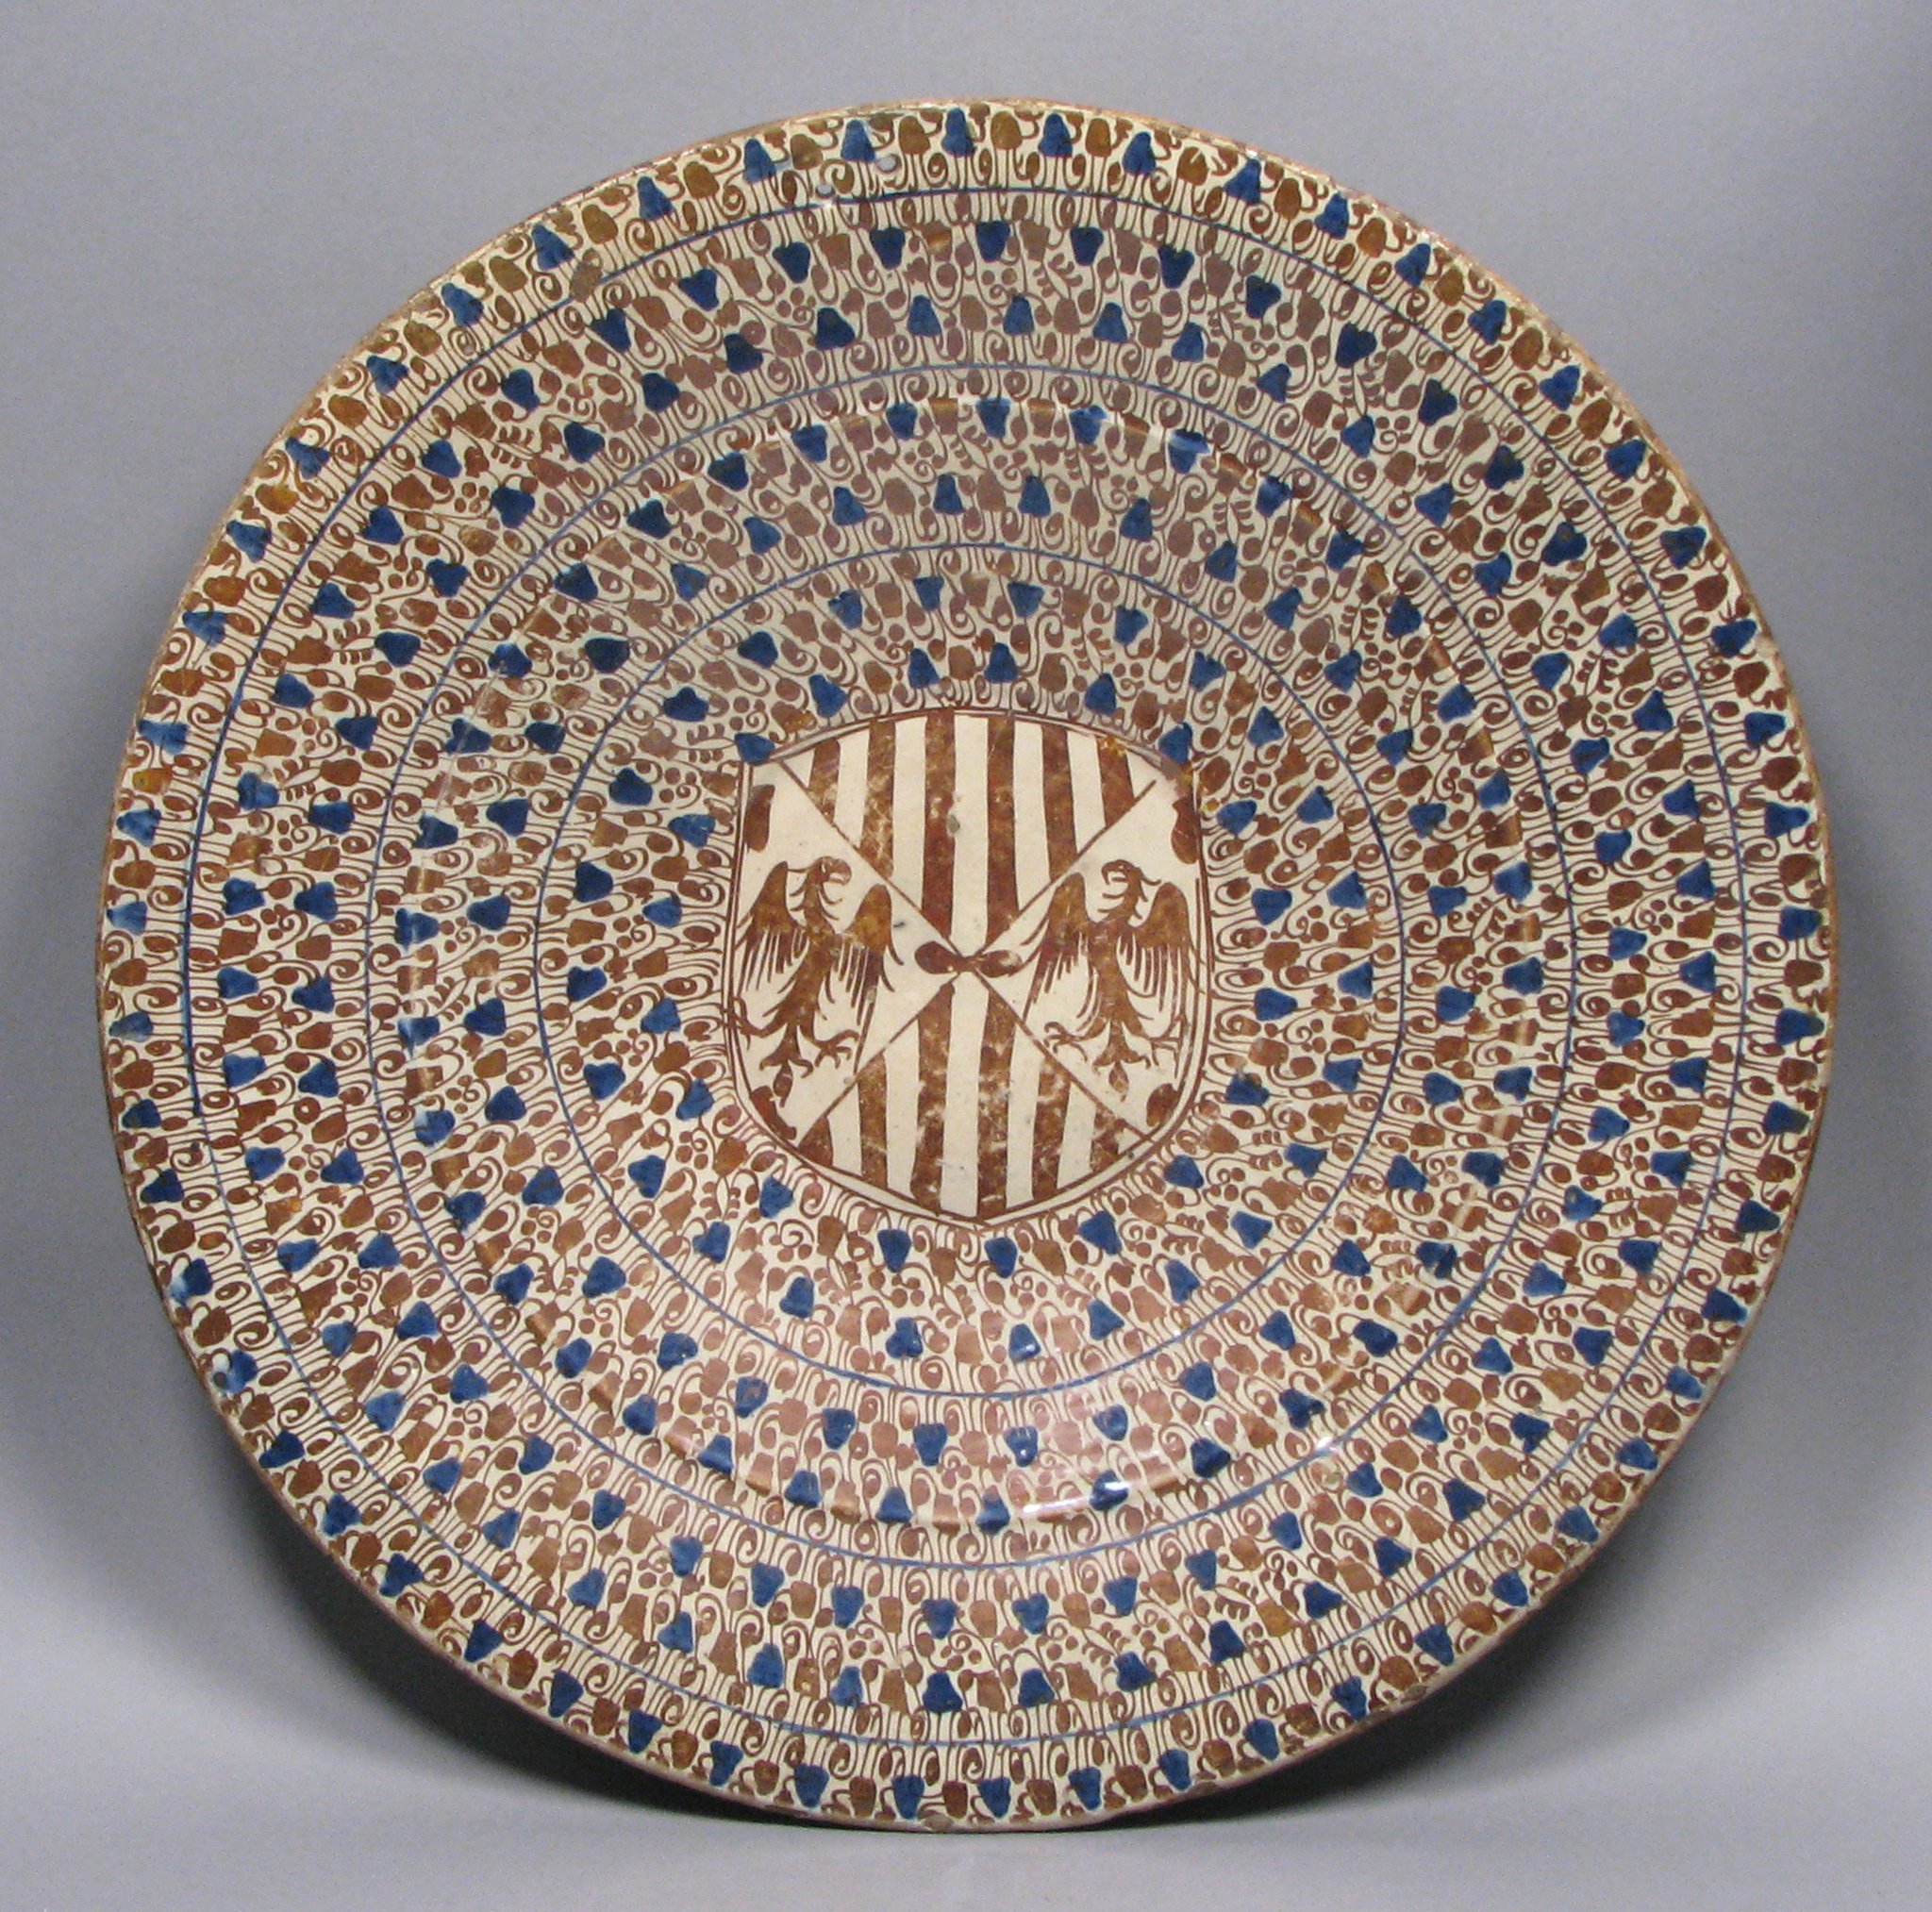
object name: dish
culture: spanish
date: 1451-1500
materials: earthenware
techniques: glazing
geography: spain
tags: coat of arms